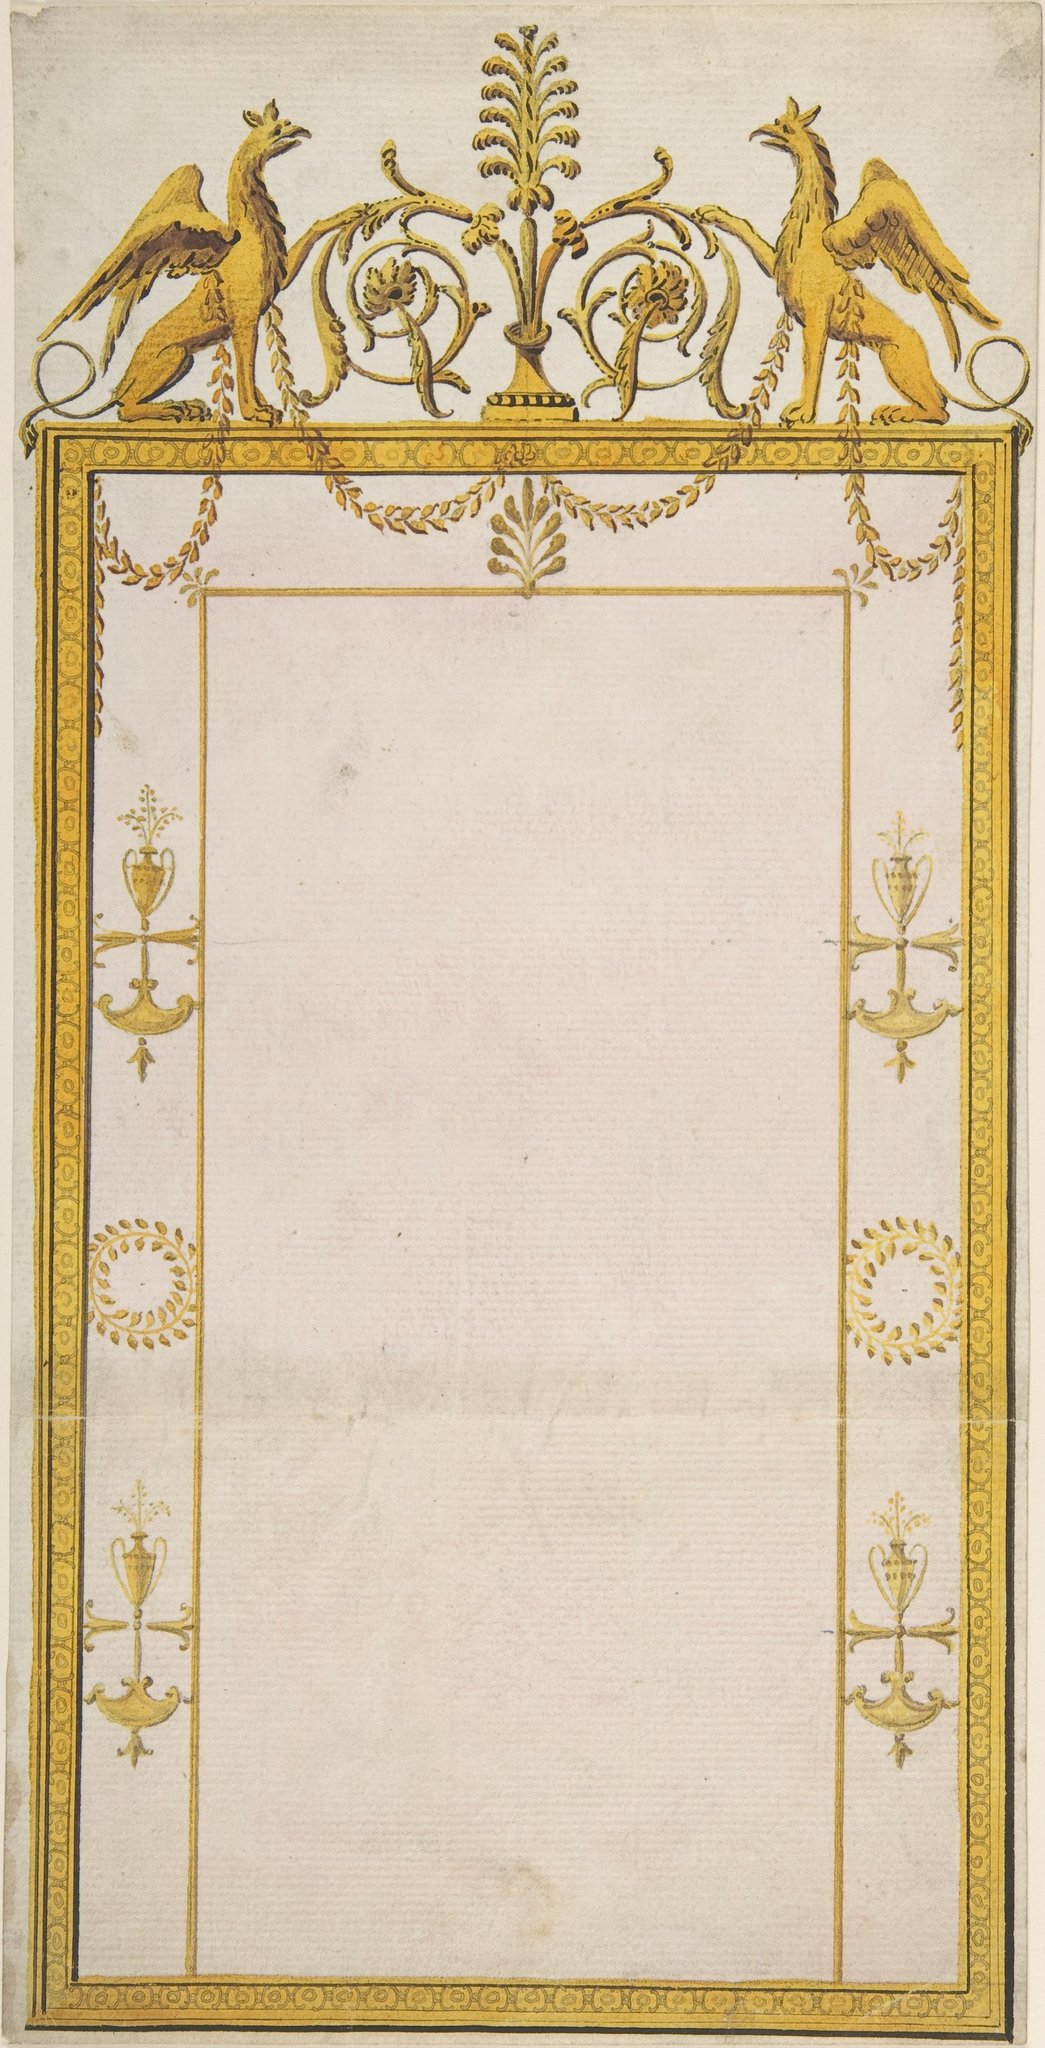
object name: drawing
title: Design for a Mirror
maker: james wyatt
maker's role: artist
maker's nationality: british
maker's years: 1746-1813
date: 1734-1833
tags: griffins,mirrors